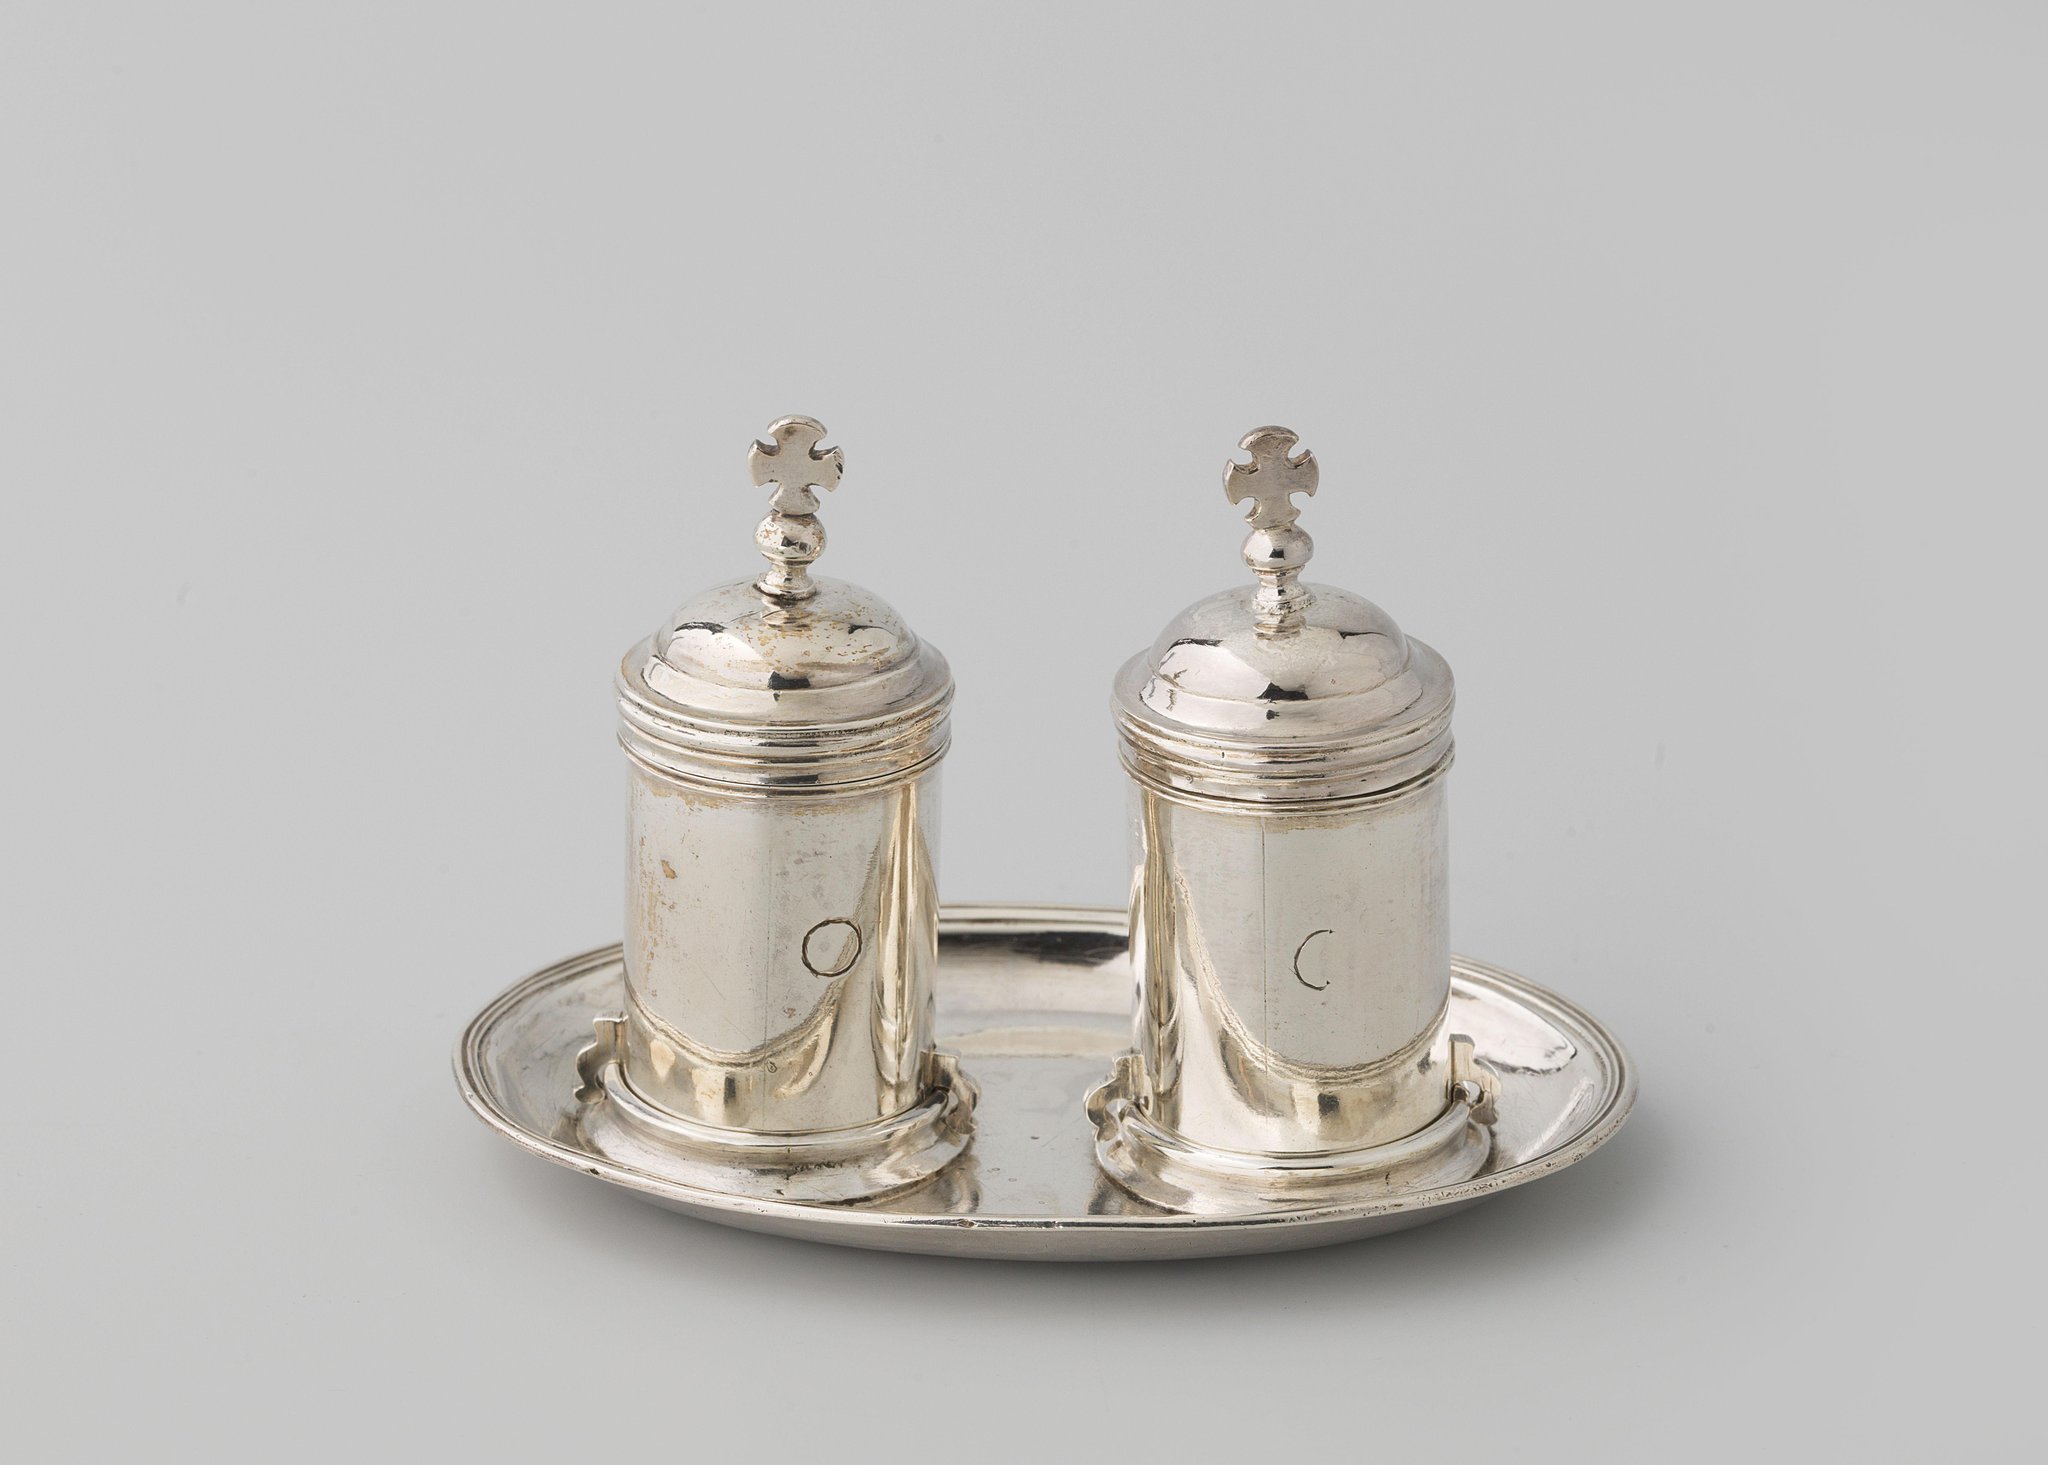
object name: bus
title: Bus behorend bij chrismatorium, op de wand de letter O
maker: p.i. dupret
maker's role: silversmith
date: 1774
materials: silver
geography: ghent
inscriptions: mark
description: Chrismatory. Silver.Ghent, 1774, by P.I. Dupret.